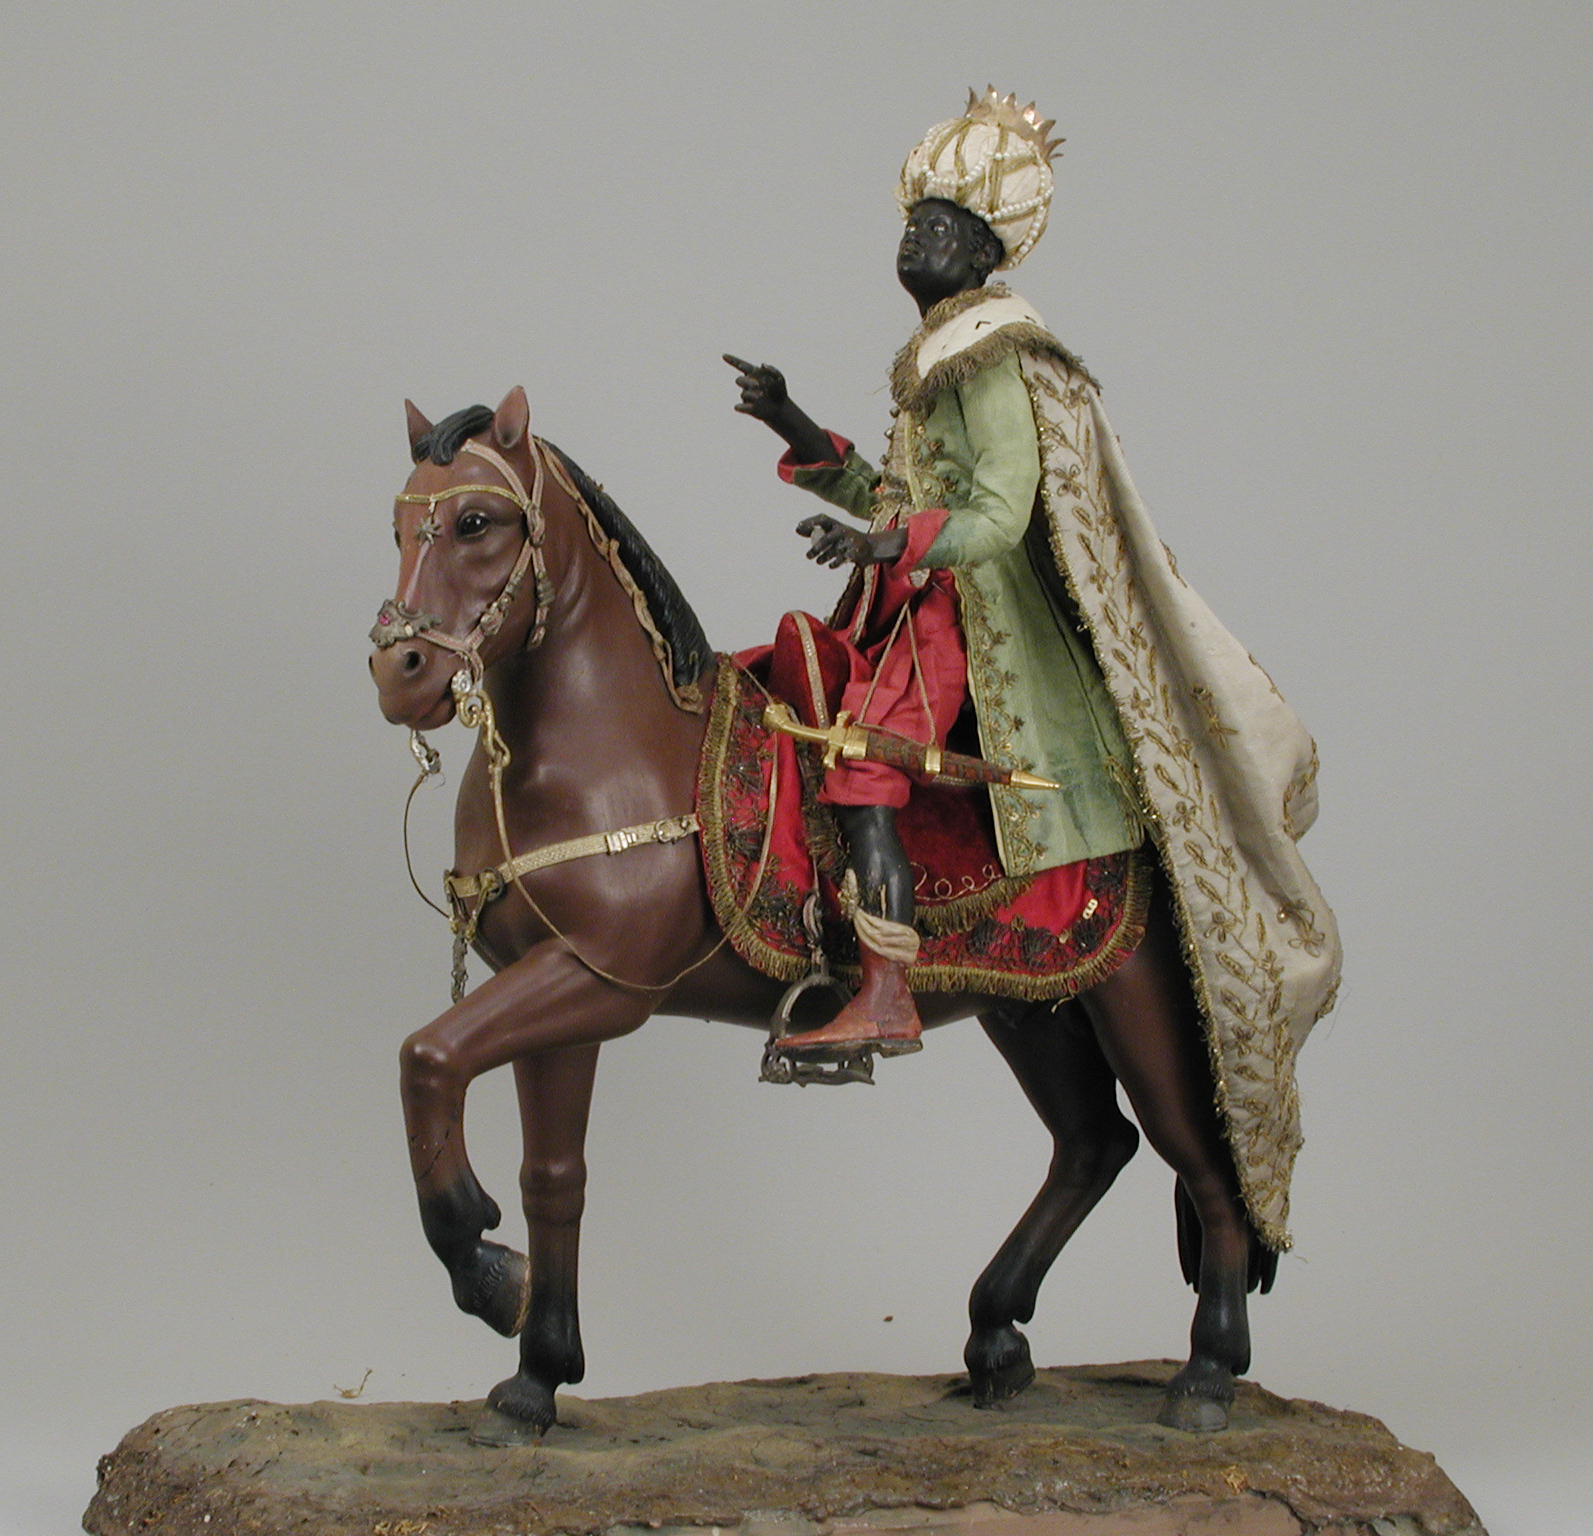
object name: crèche figure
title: Brown horse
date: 1751-1800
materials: gilt, gold, metal thread, textile, silver, terracotta, velvet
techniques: polychrome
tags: horses